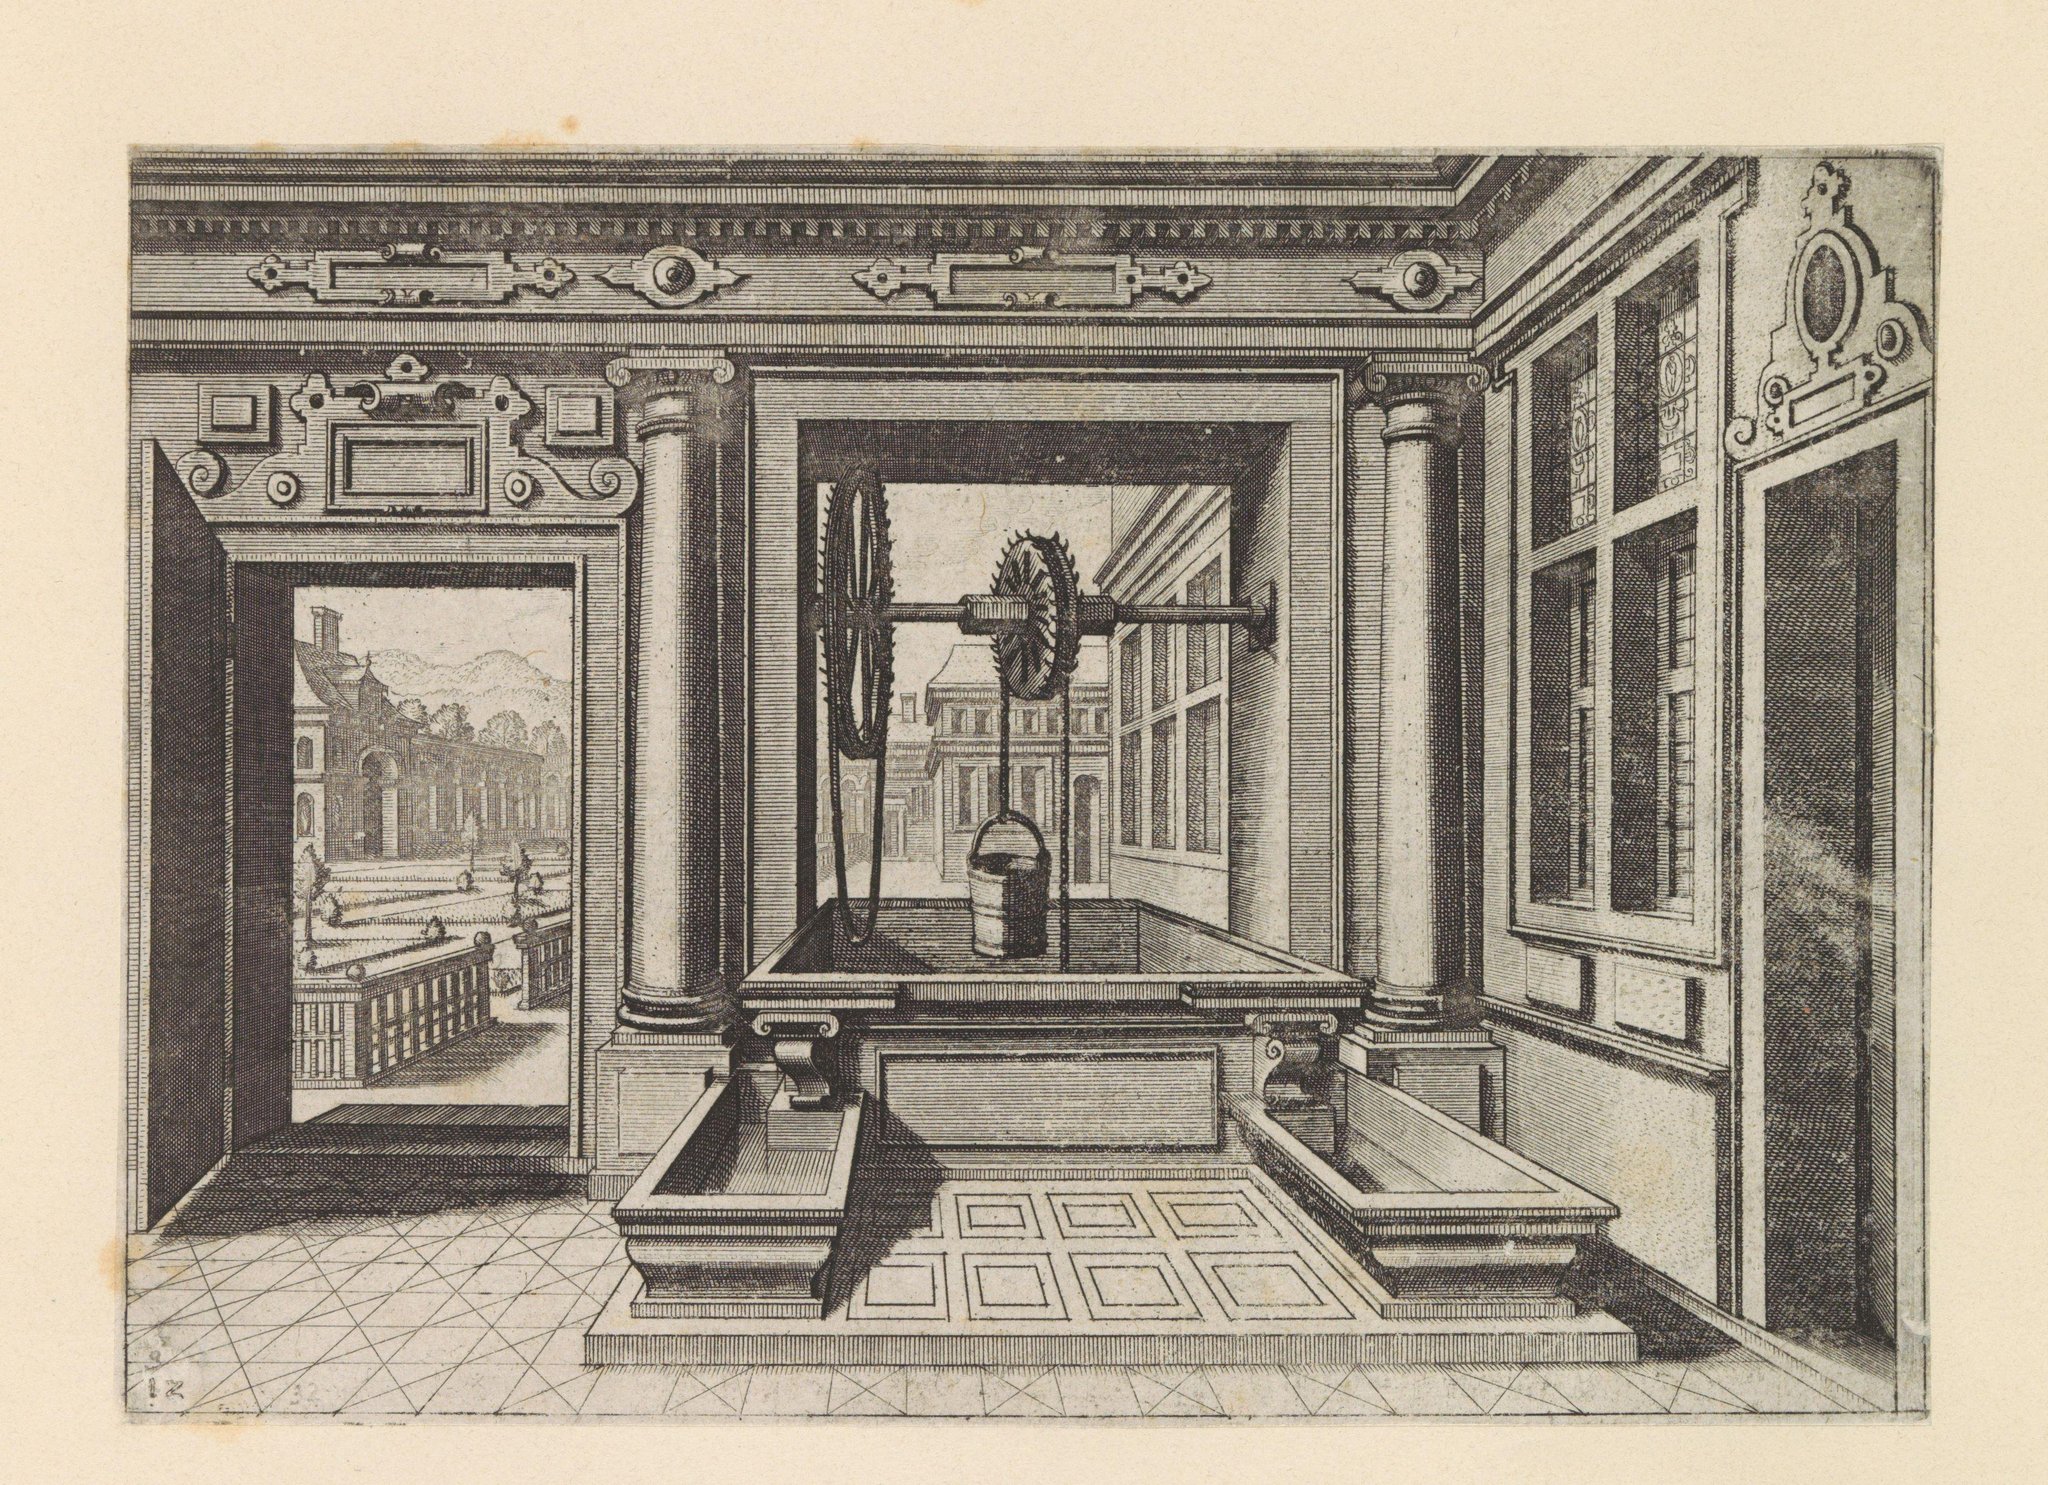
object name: ornament print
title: Waterputten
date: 1574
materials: paper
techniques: etching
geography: antwerp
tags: well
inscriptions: inscription: ‘3’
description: Rechthoekige put, ingebouwd in de scheidingswand tussen een binnenplaats en een tuin. De aker hangt aan een hijsinrichting met twee kettingwielen. De prent maakt deel uit van een album.